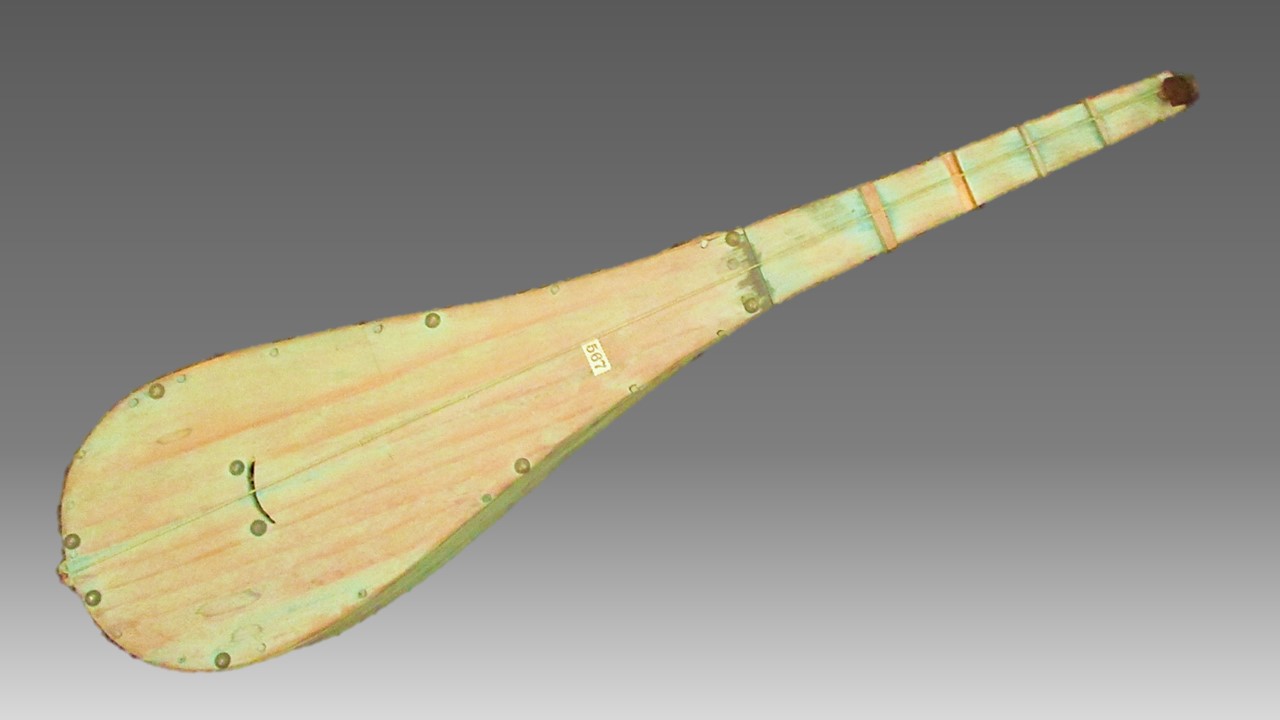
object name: lute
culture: native american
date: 1801-1900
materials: paint, wood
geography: united states